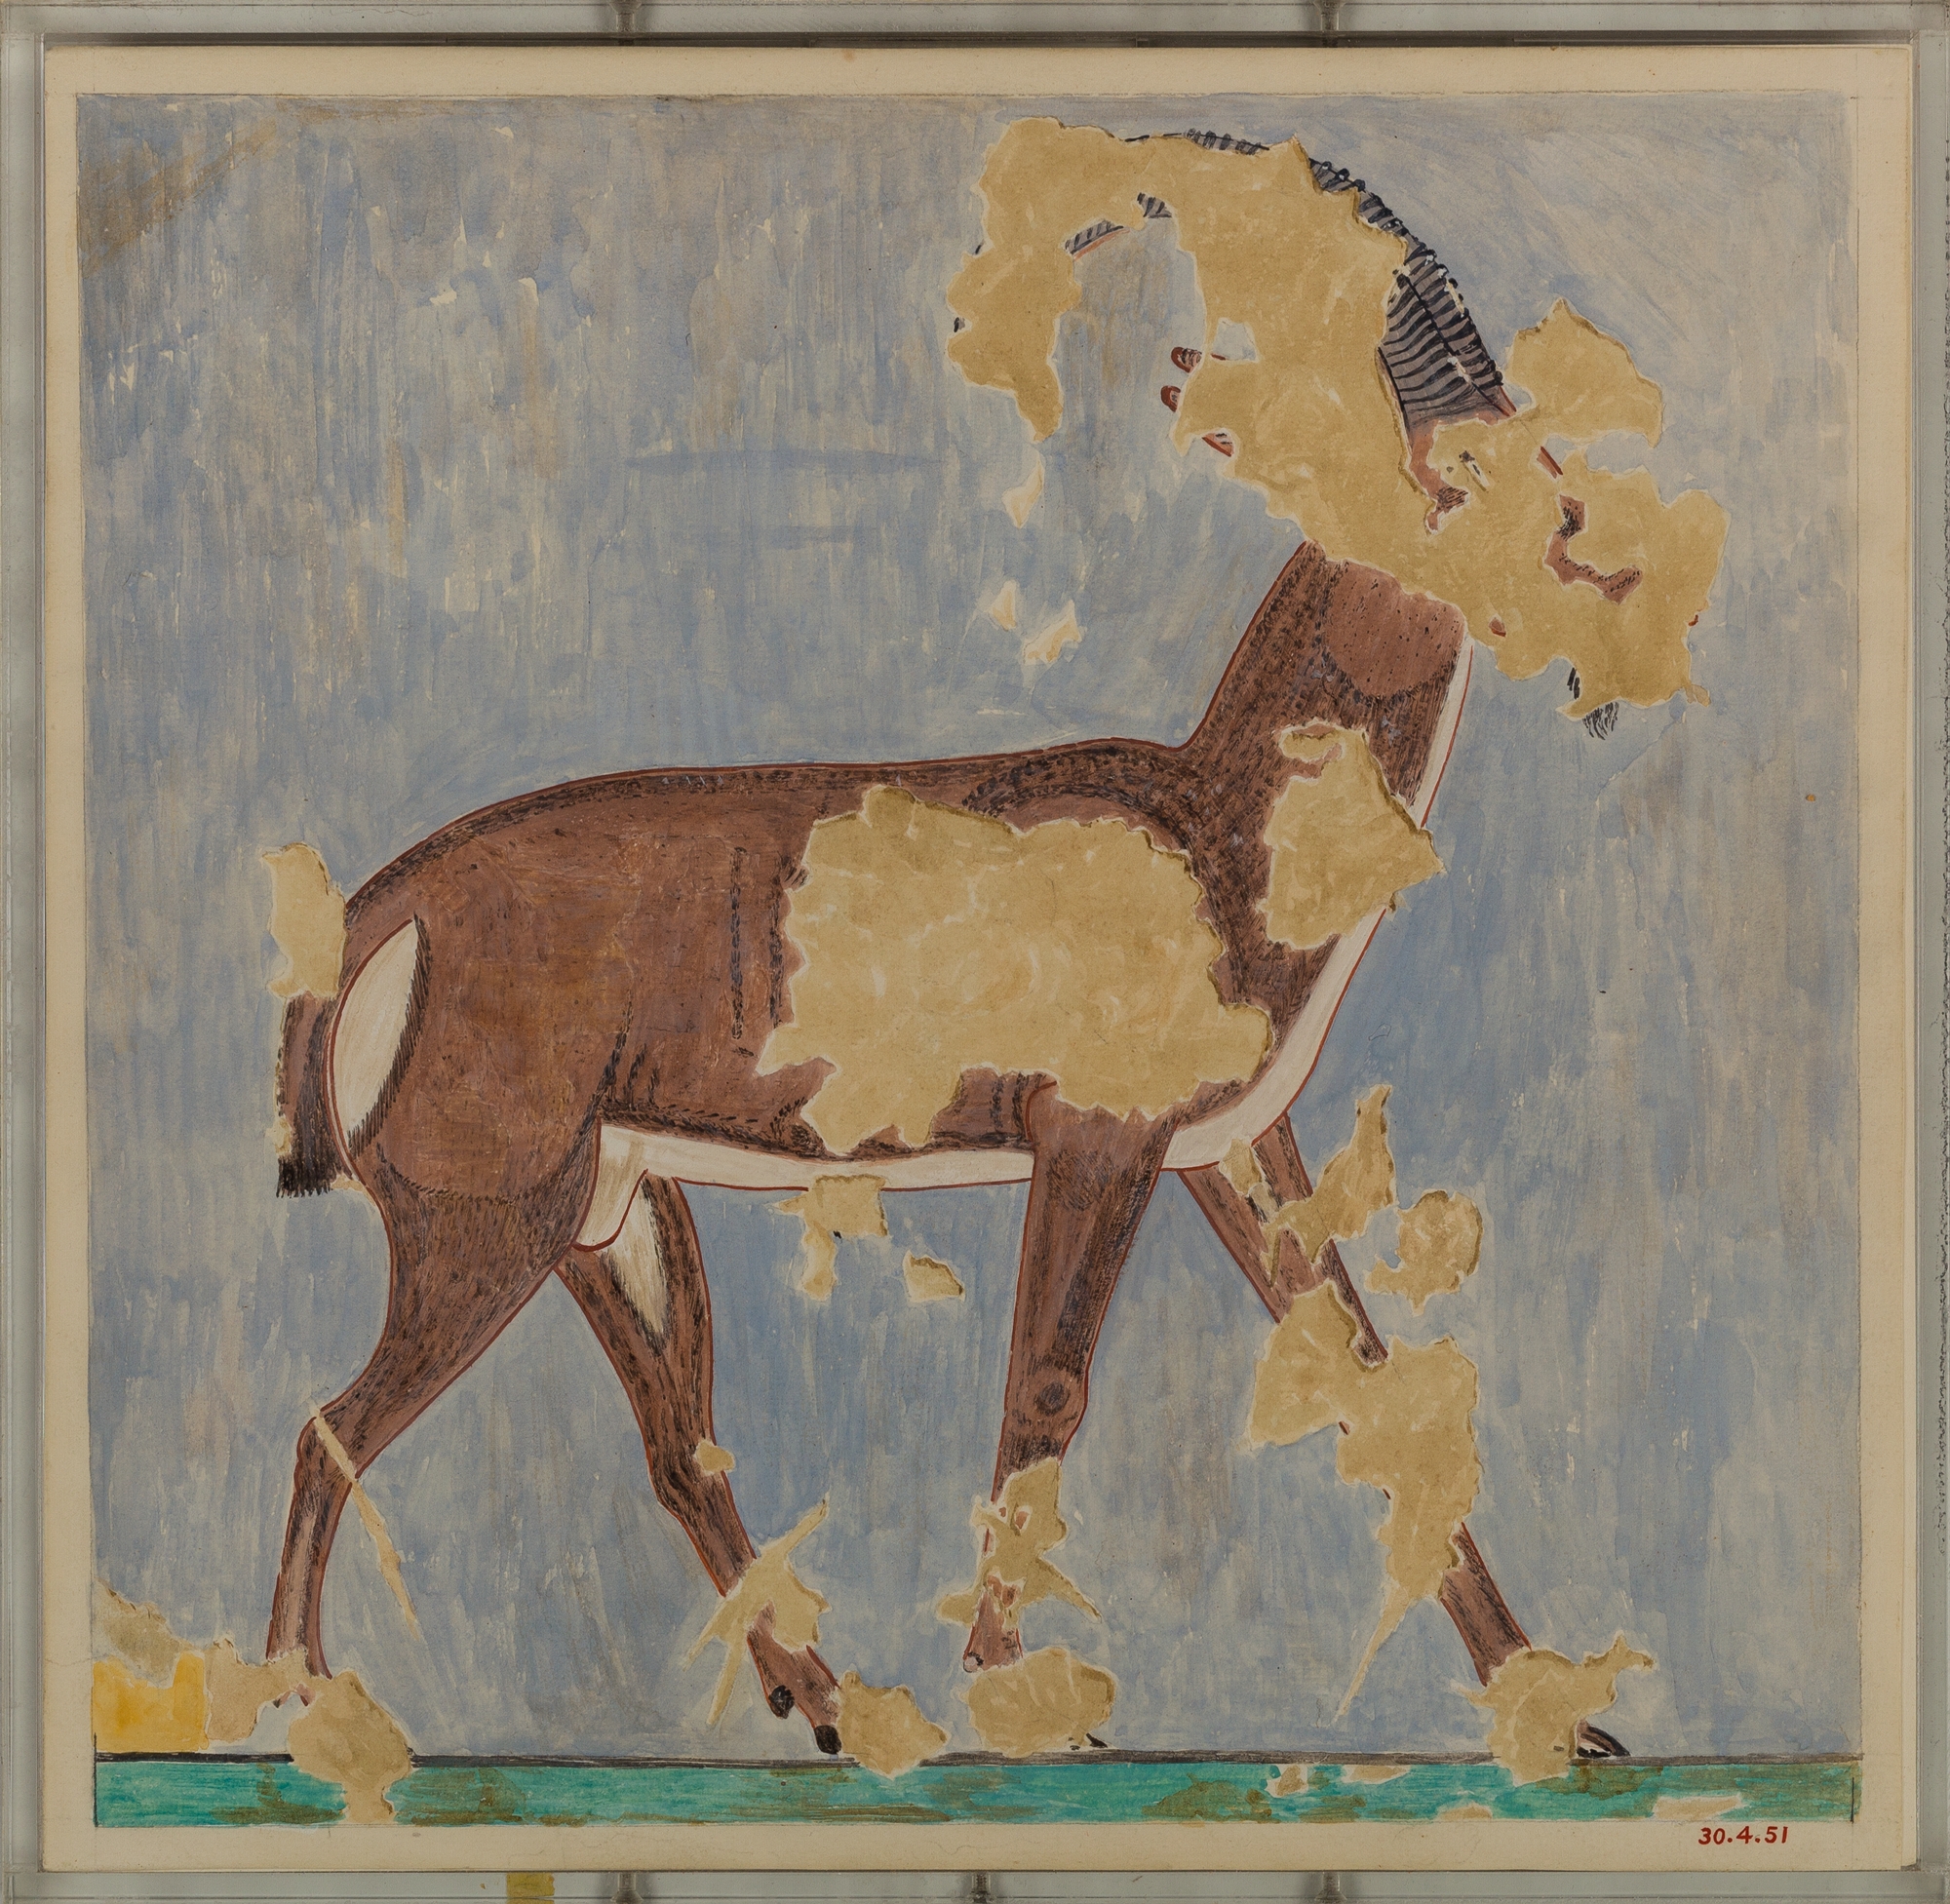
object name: facsimile, amenhotep tt 73, ibex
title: Ibex, Tomb of Amenhotep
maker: nina de garis davies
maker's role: artist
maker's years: 1881-1965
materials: paper, paint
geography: egypt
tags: ibex